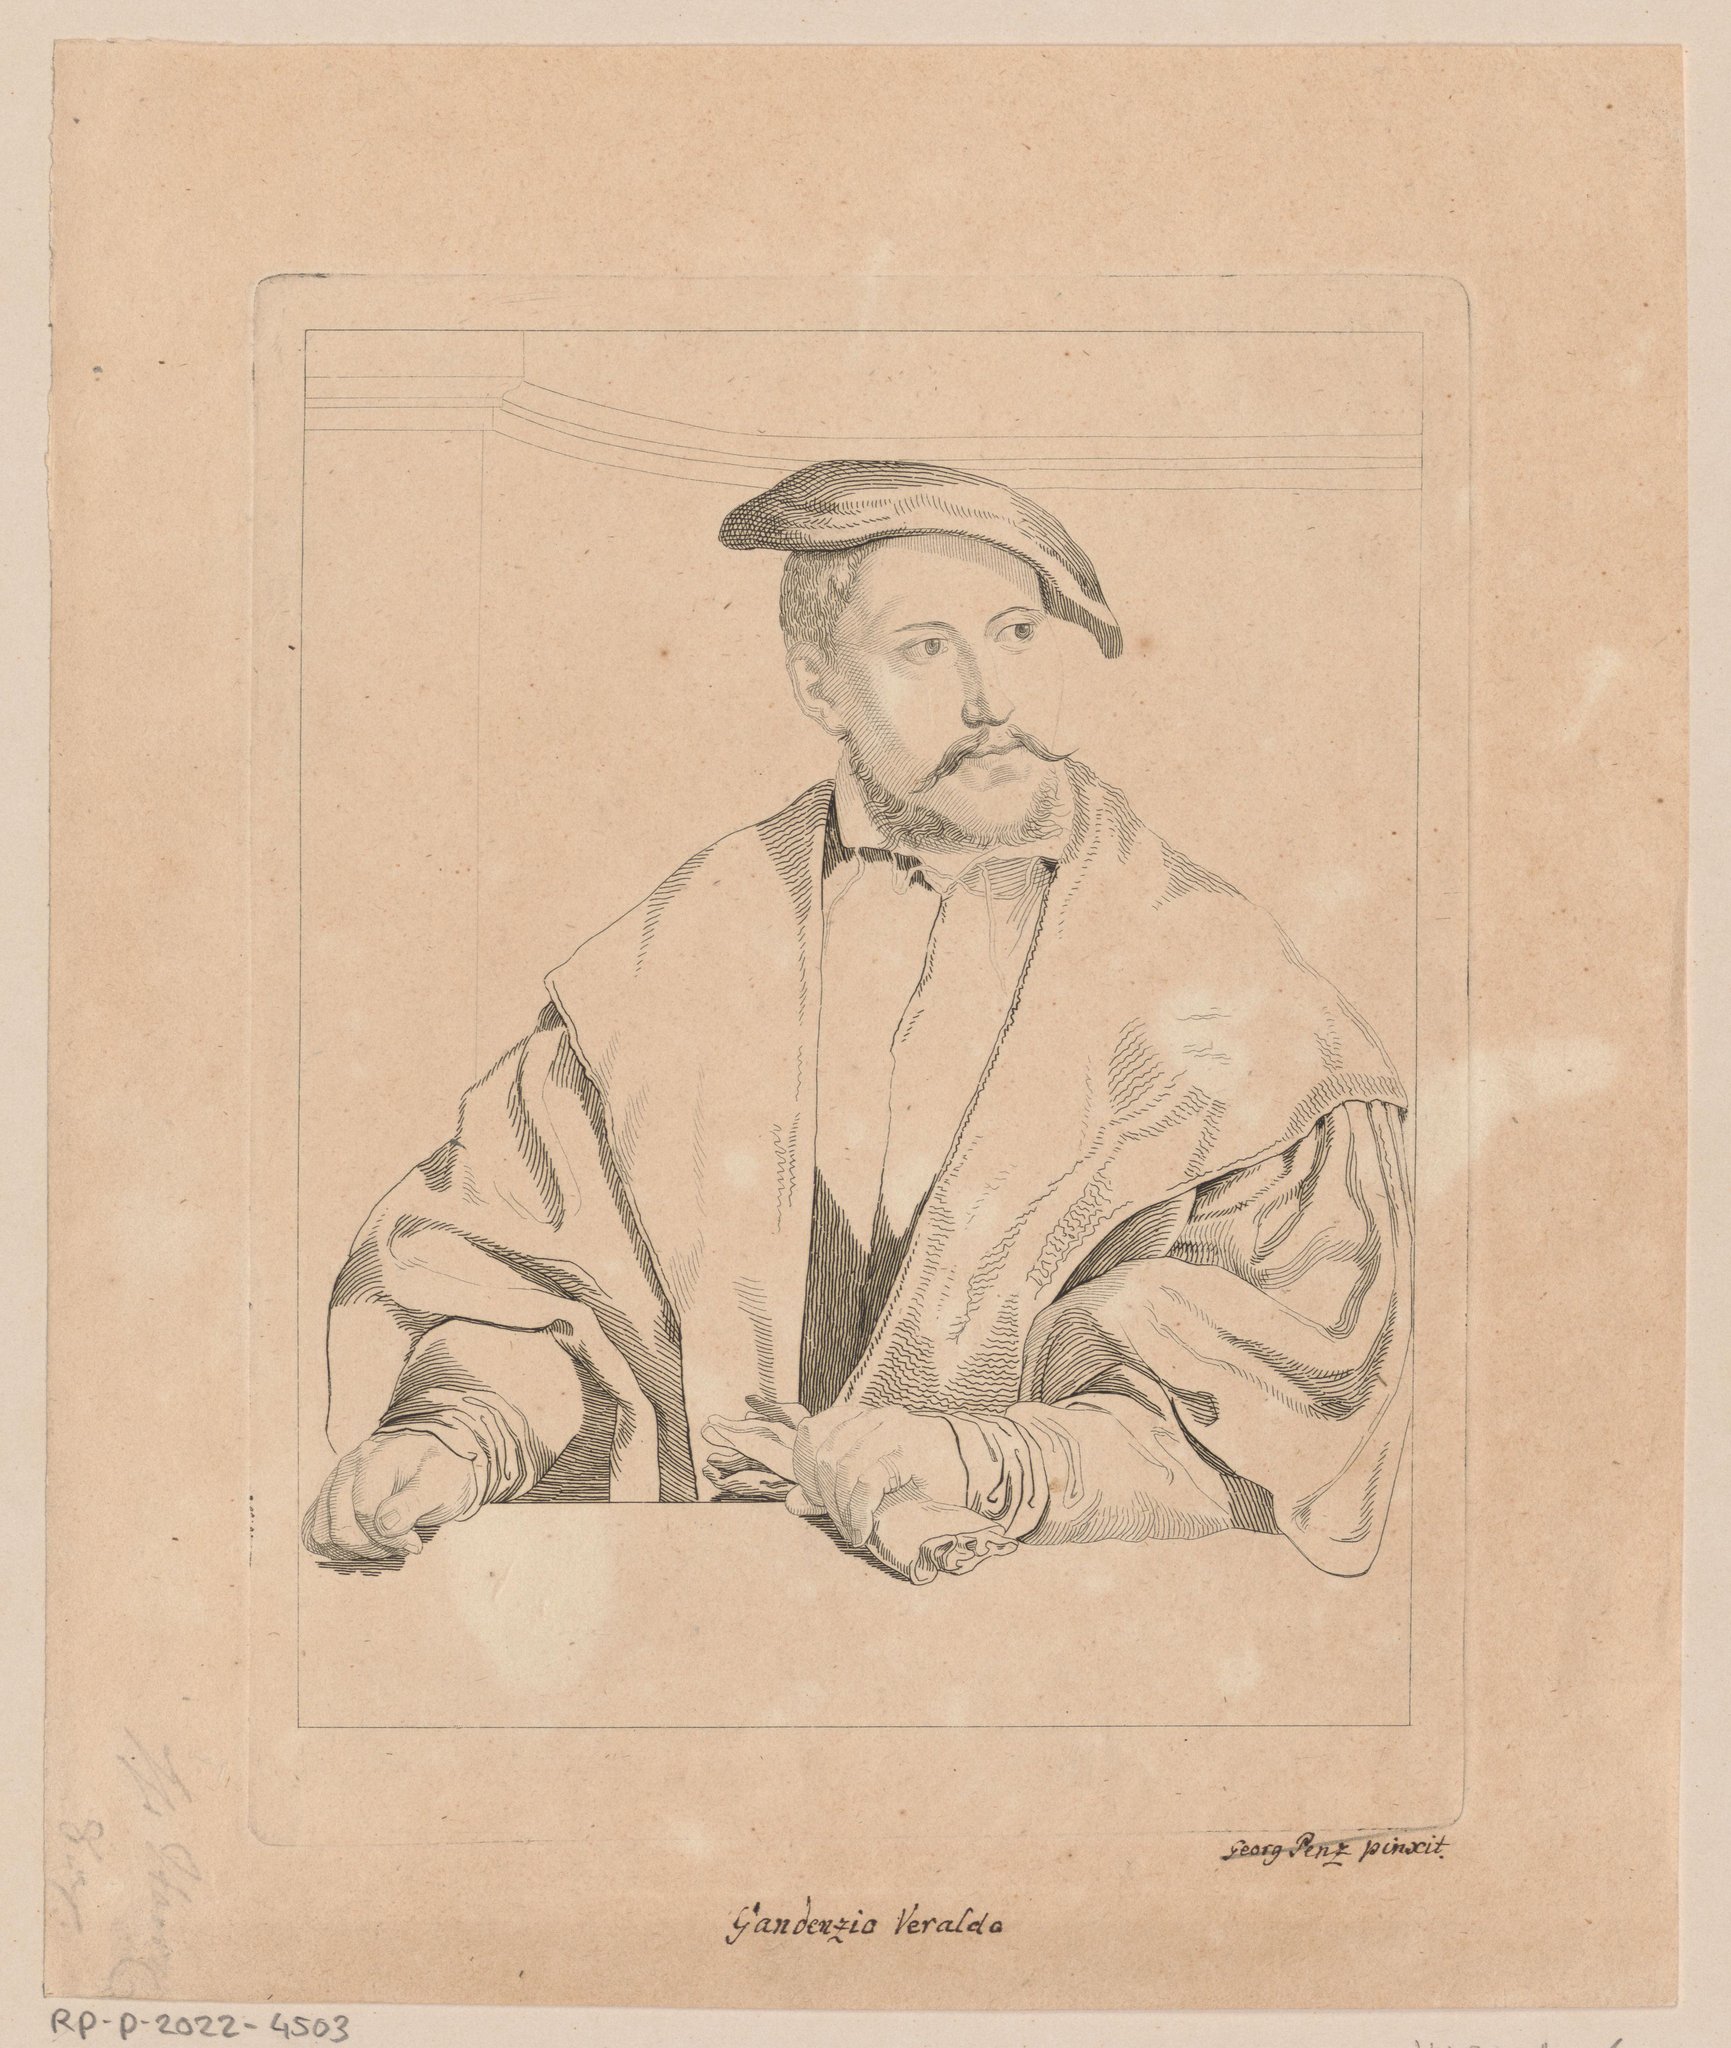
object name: print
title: Portret van een man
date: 1800-1899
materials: paper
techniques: etching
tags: anonymous historical person portrayed alone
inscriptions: inscription: ‘Gandenzia Veralda’, inscription: ‘Georf Penz pinxit’